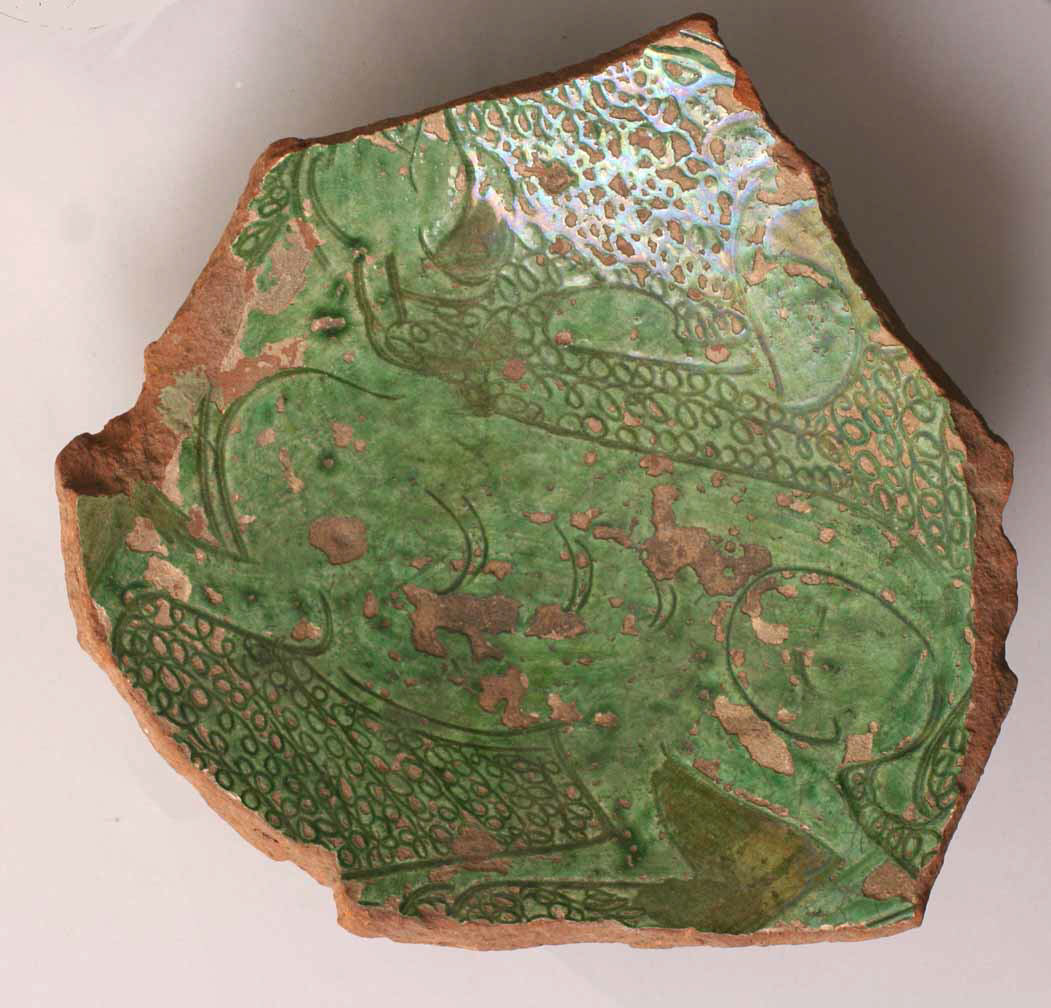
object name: fragment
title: Ceramic Fragment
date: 1301-1400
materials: earthenware, glaze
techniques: coloring, incising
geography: egypt